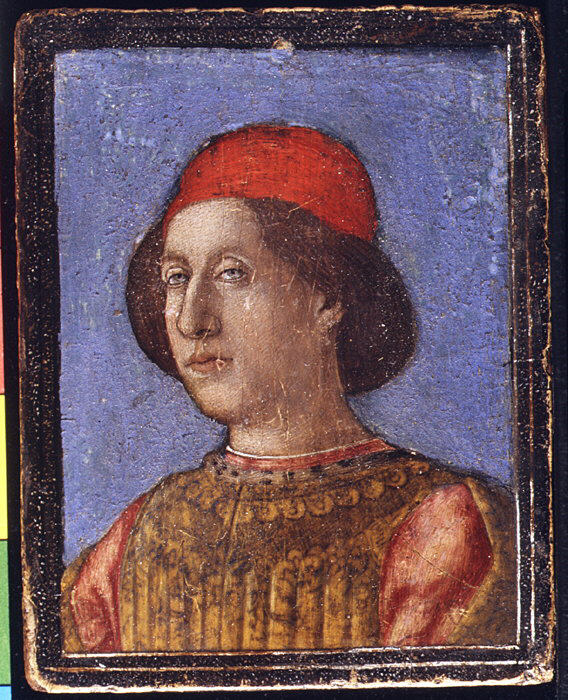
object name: painting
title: Rodolfo Gonzaga (1451–1495)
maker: andrea mantegna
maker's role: artist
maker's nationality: italian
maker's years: 1431-1506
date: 1490-1495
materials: paint, wood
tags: men,portraits